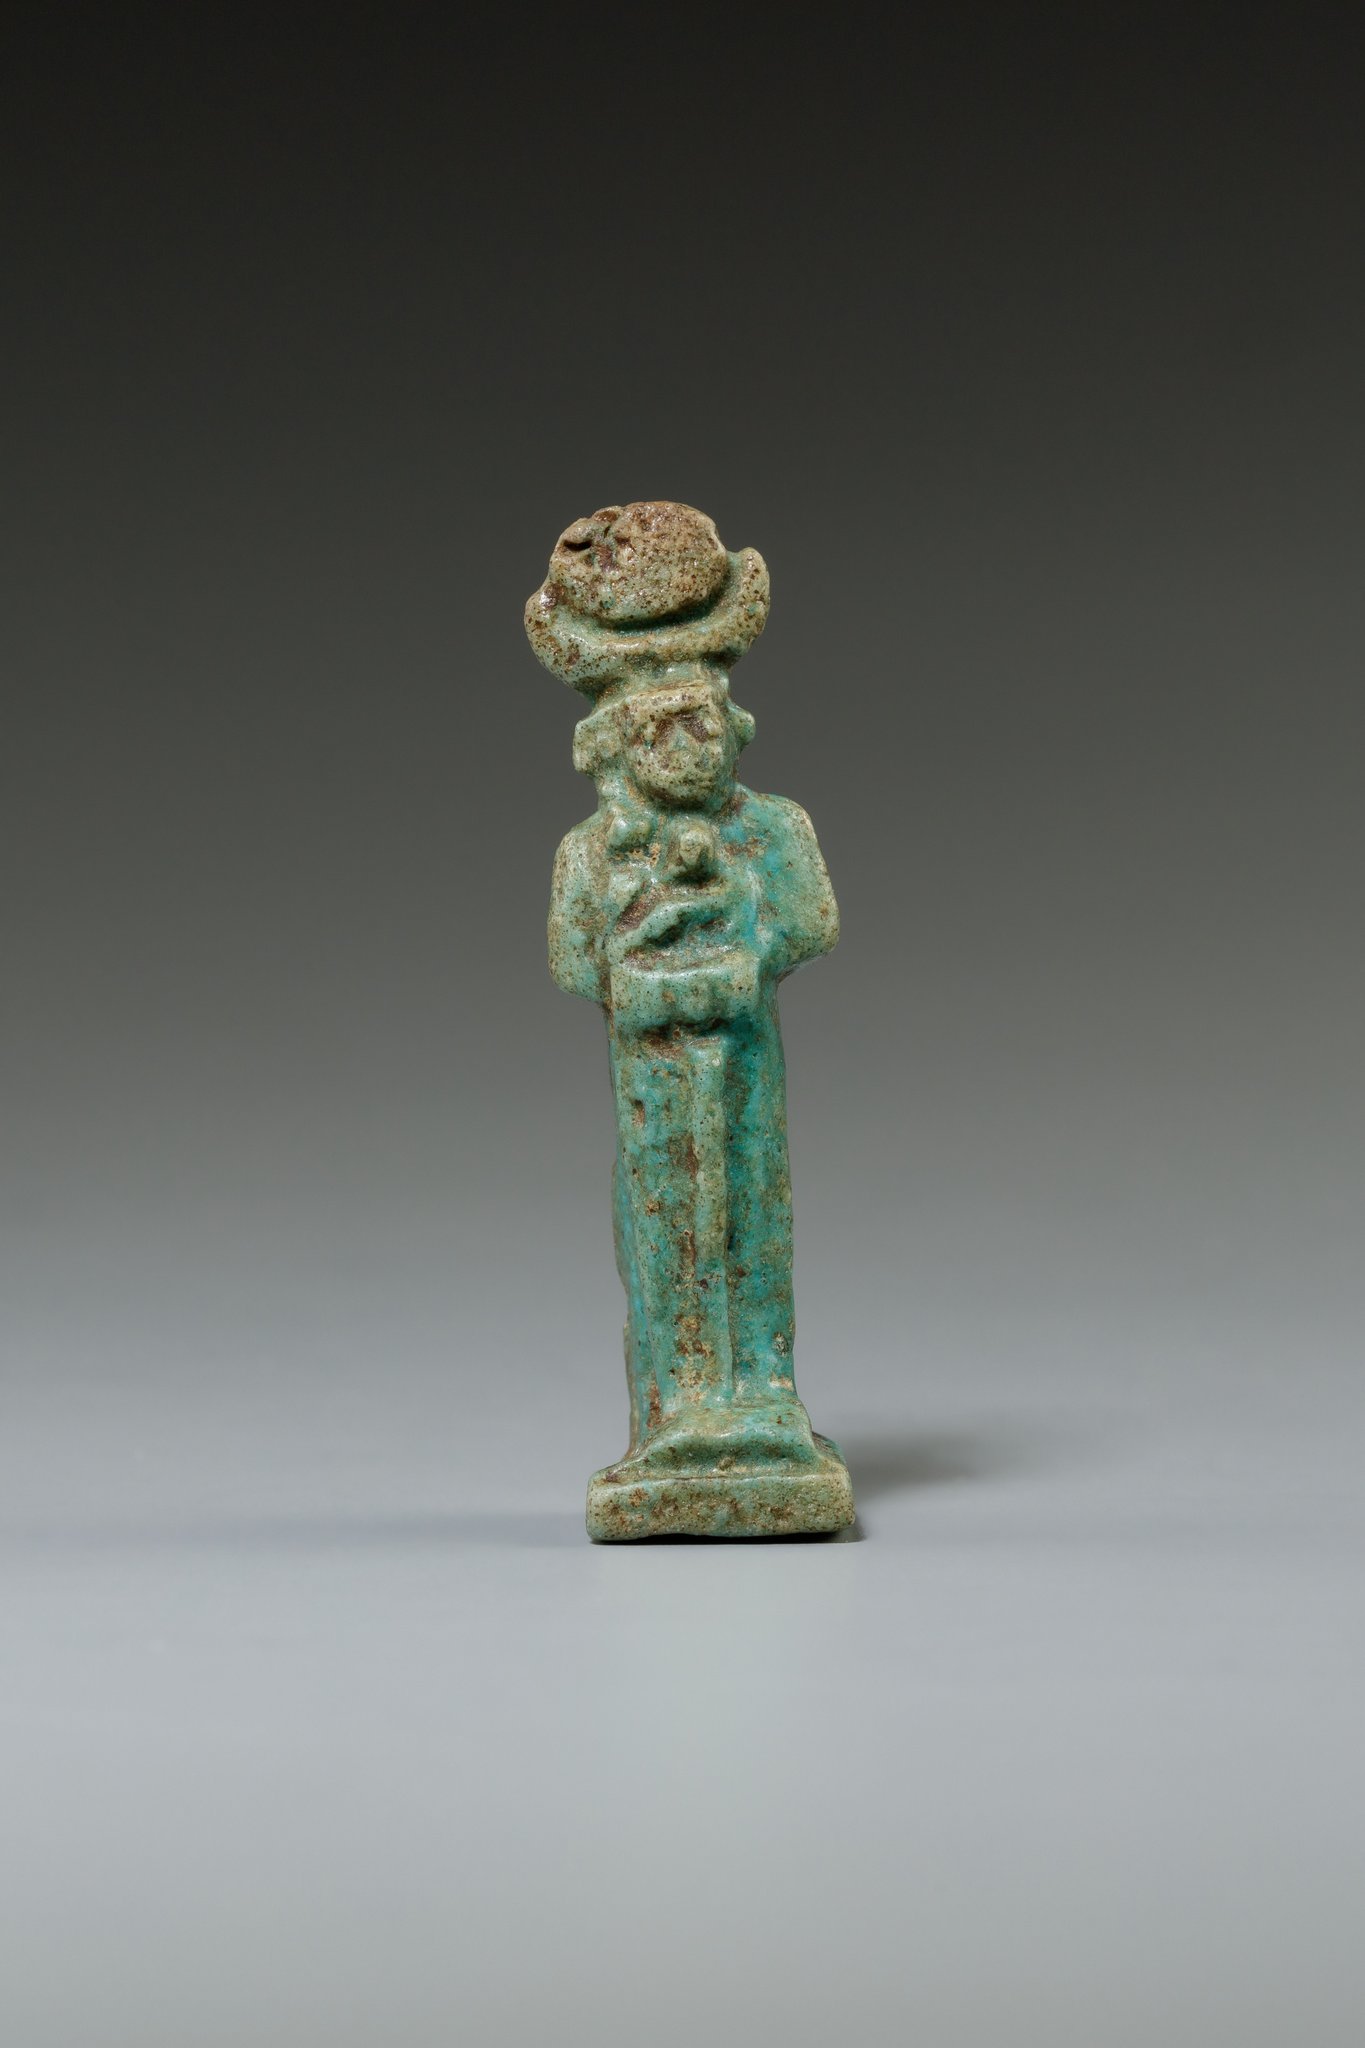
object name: amulet, khonsu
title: Khonsu amulet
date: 664-630 BCE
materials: faience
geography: egypt